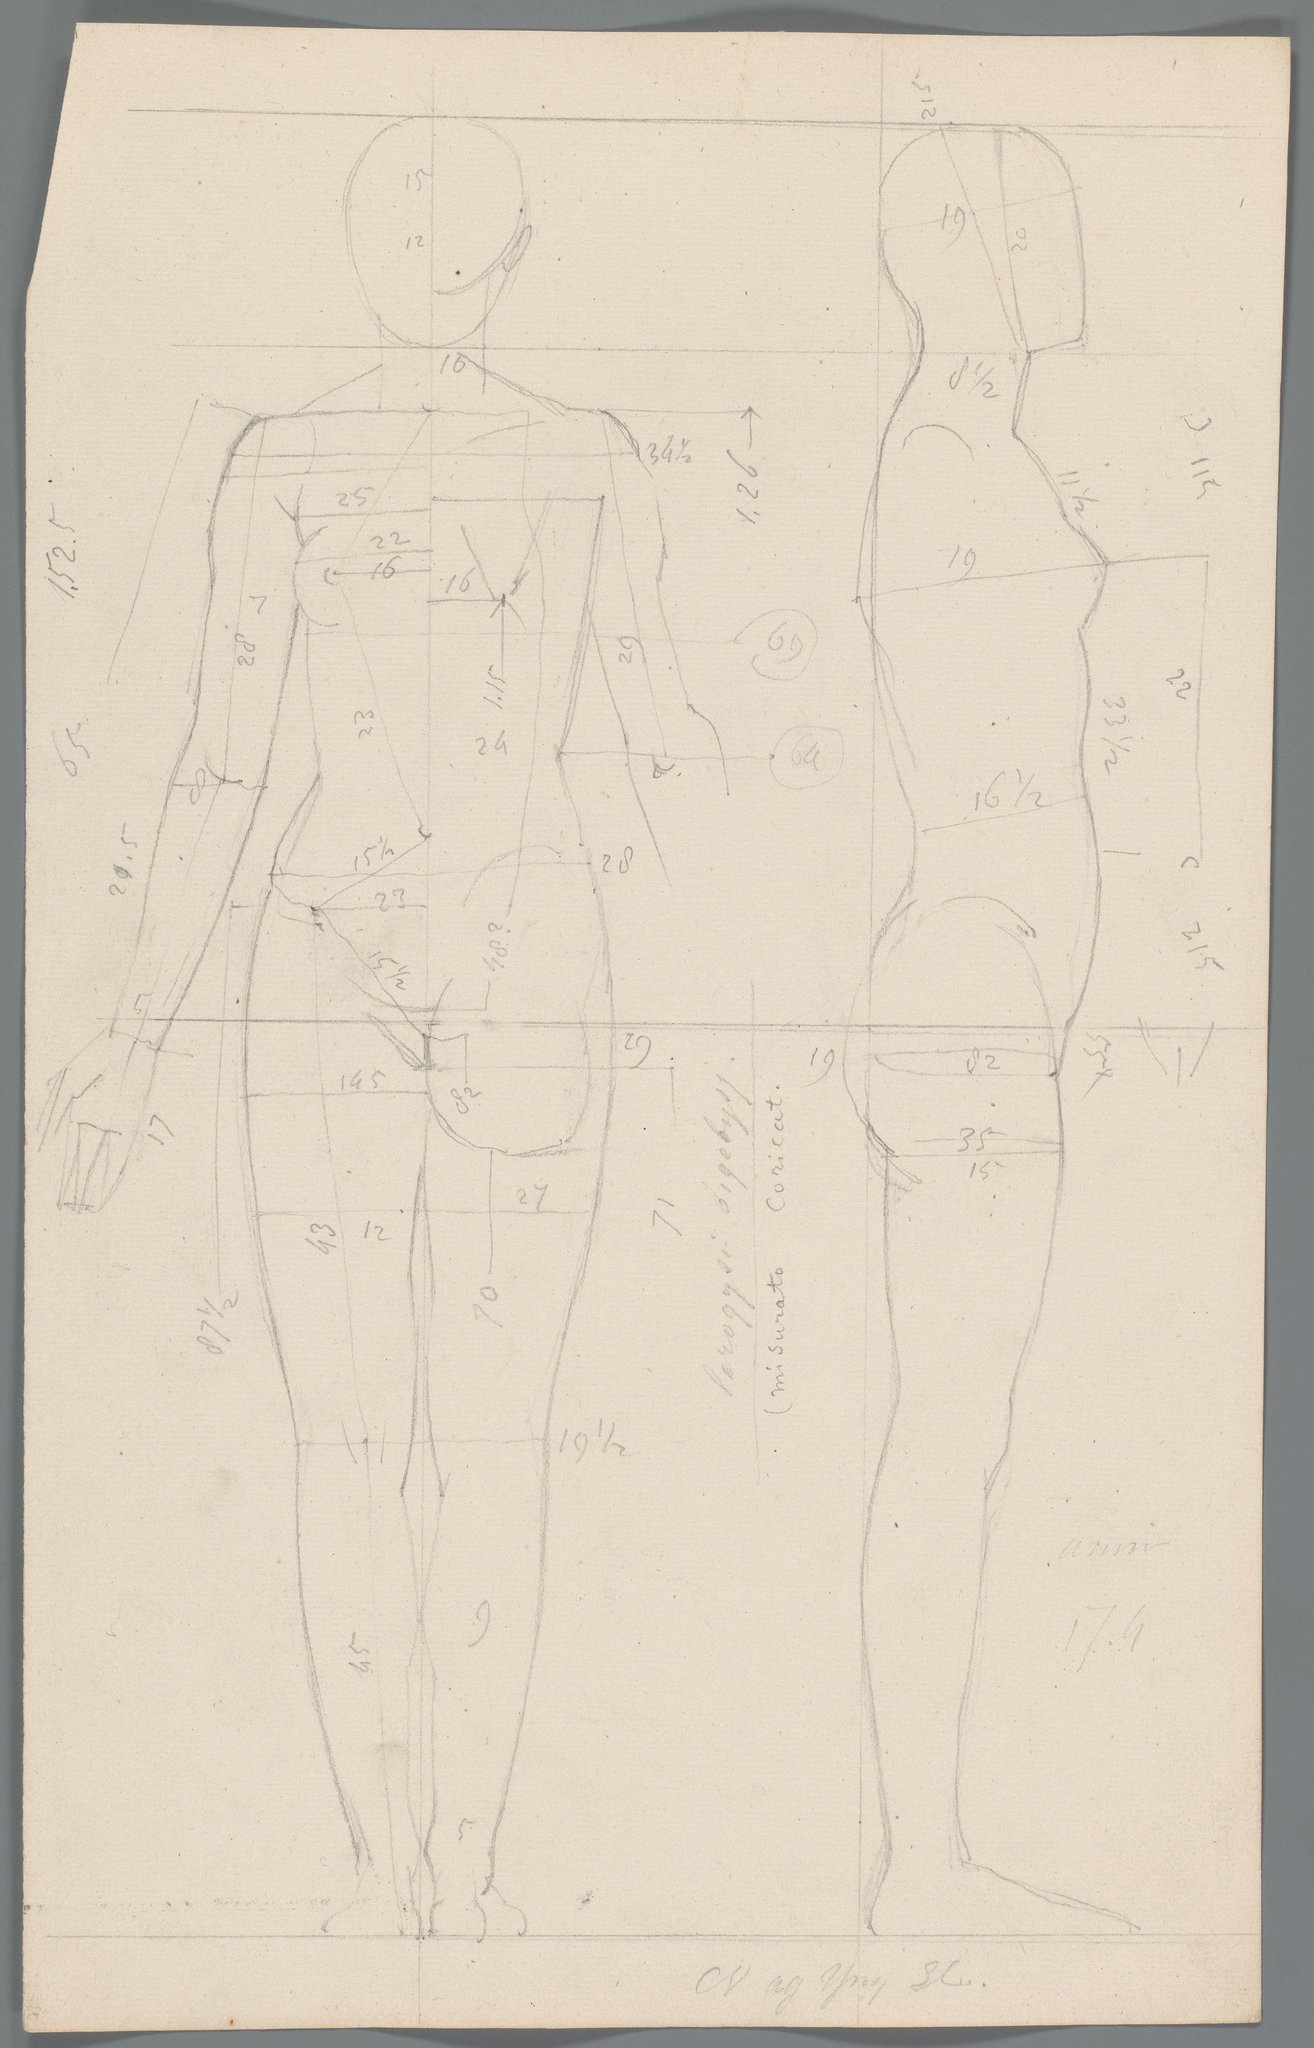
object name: drawing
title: Proportiestudie van een vrouw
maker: jacobus everhardus josephus van den berg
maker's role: draughtsman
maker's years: 1802-1861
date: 1853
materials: paper, pencil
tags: standing figure (canon, proportions) - aa - female human figure, anatomy (non-medical) - aa - female human figure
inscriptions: inscription: ‘CV ag Yng EC’